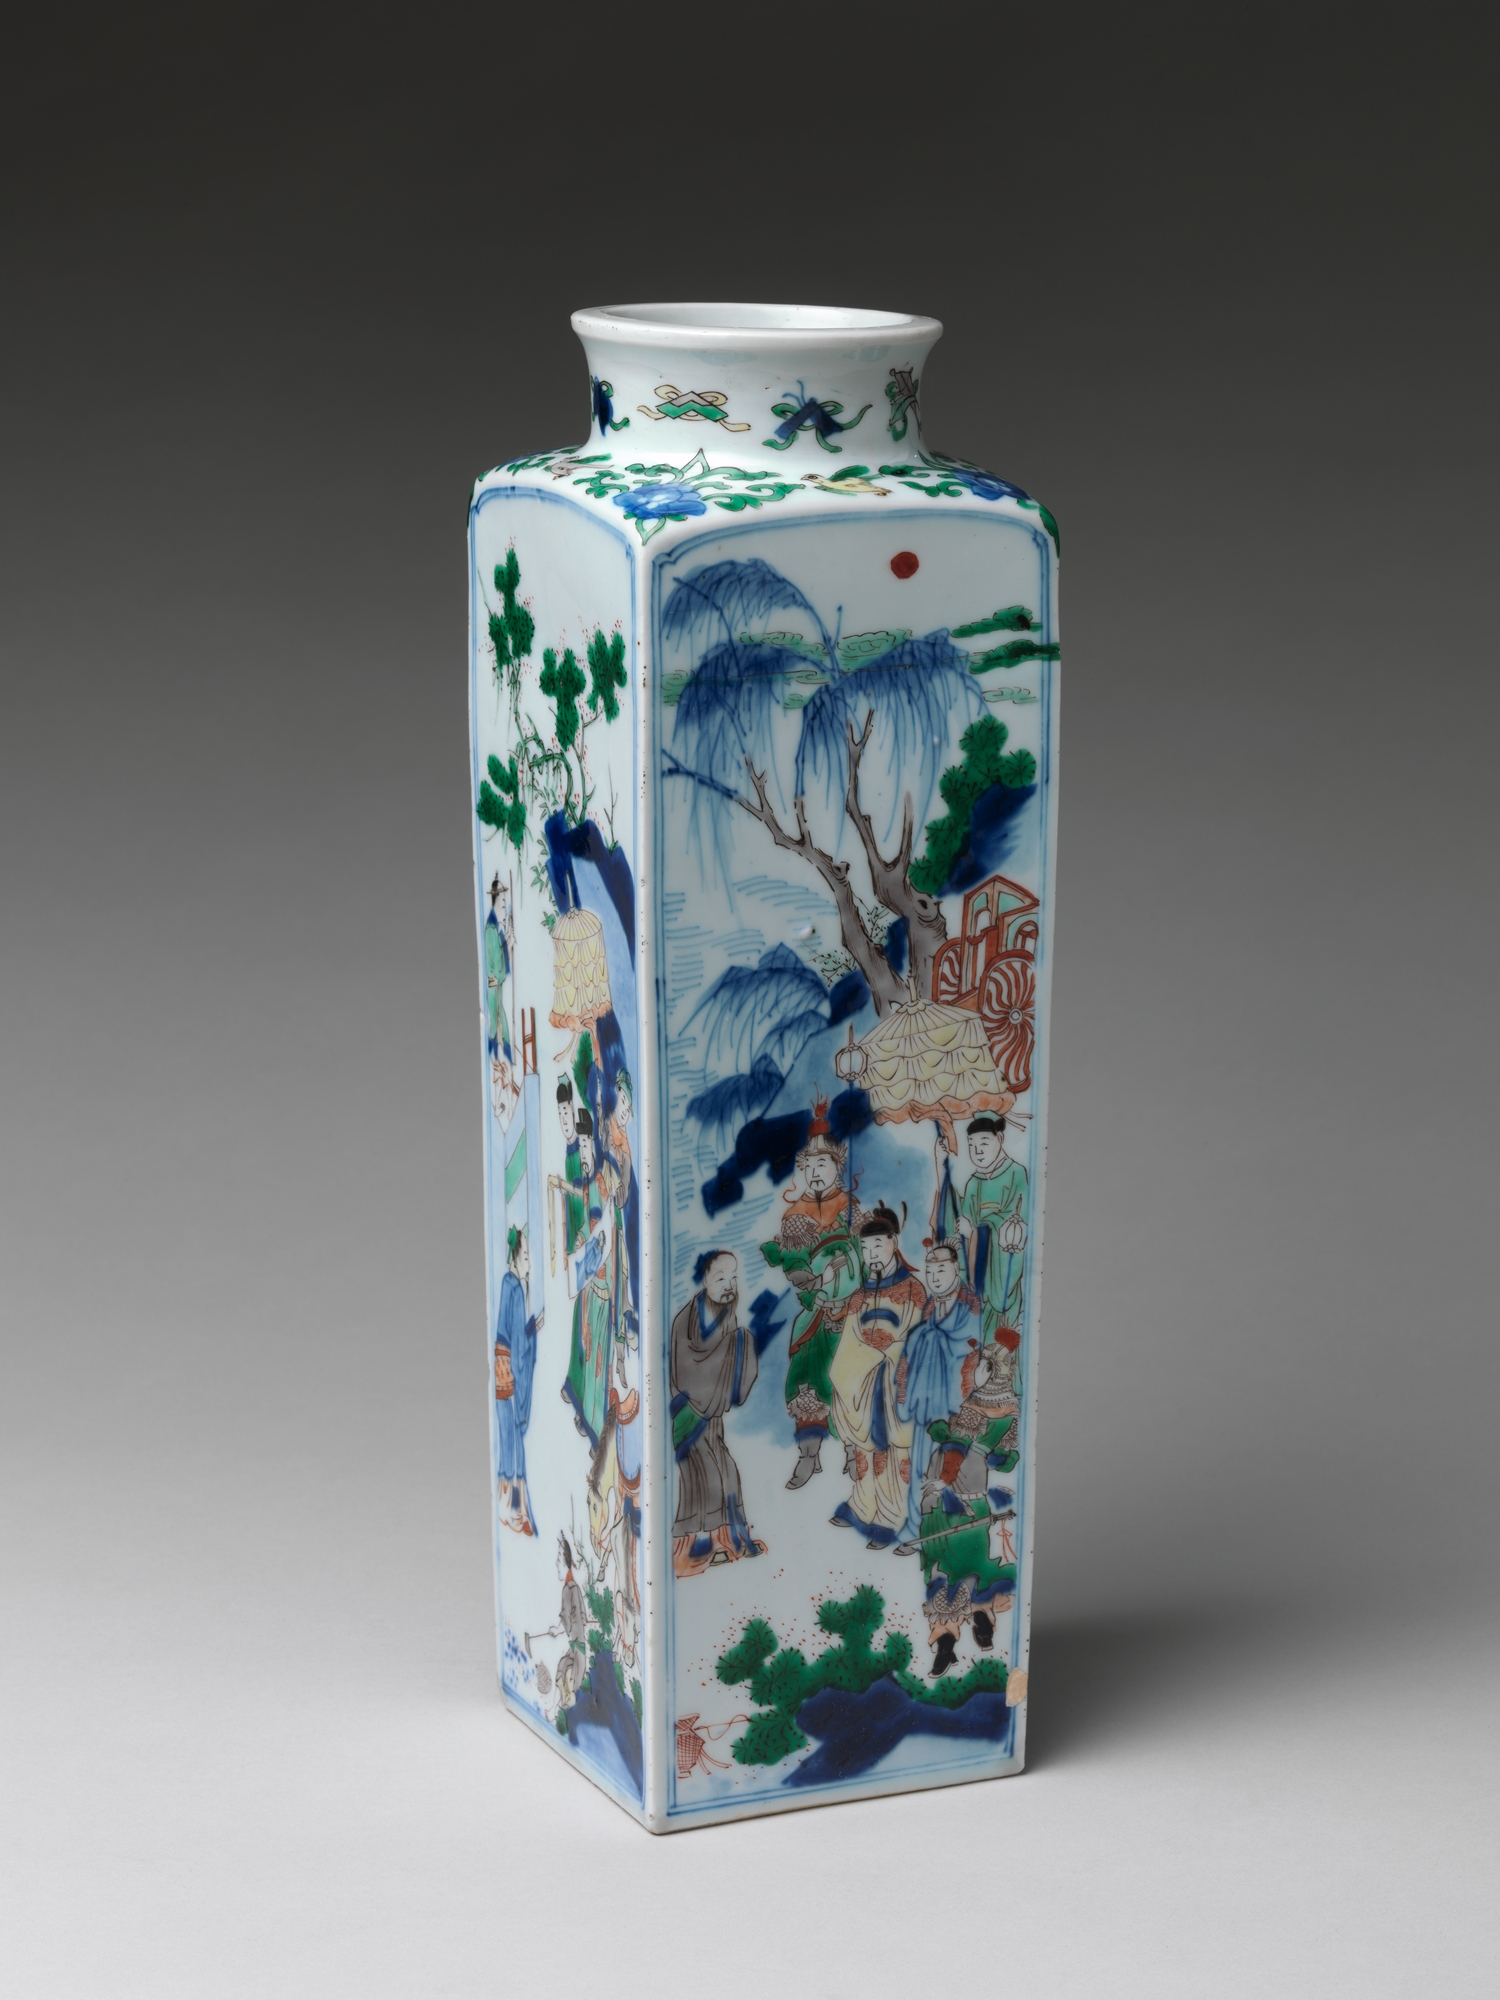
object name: vase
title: Vase with King Wen Visiting the Scholar Jiang Taigong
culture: chinese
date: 1634-1666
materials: cobalt, enamel, glaze, porcelain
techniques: painting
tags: human figures,trees